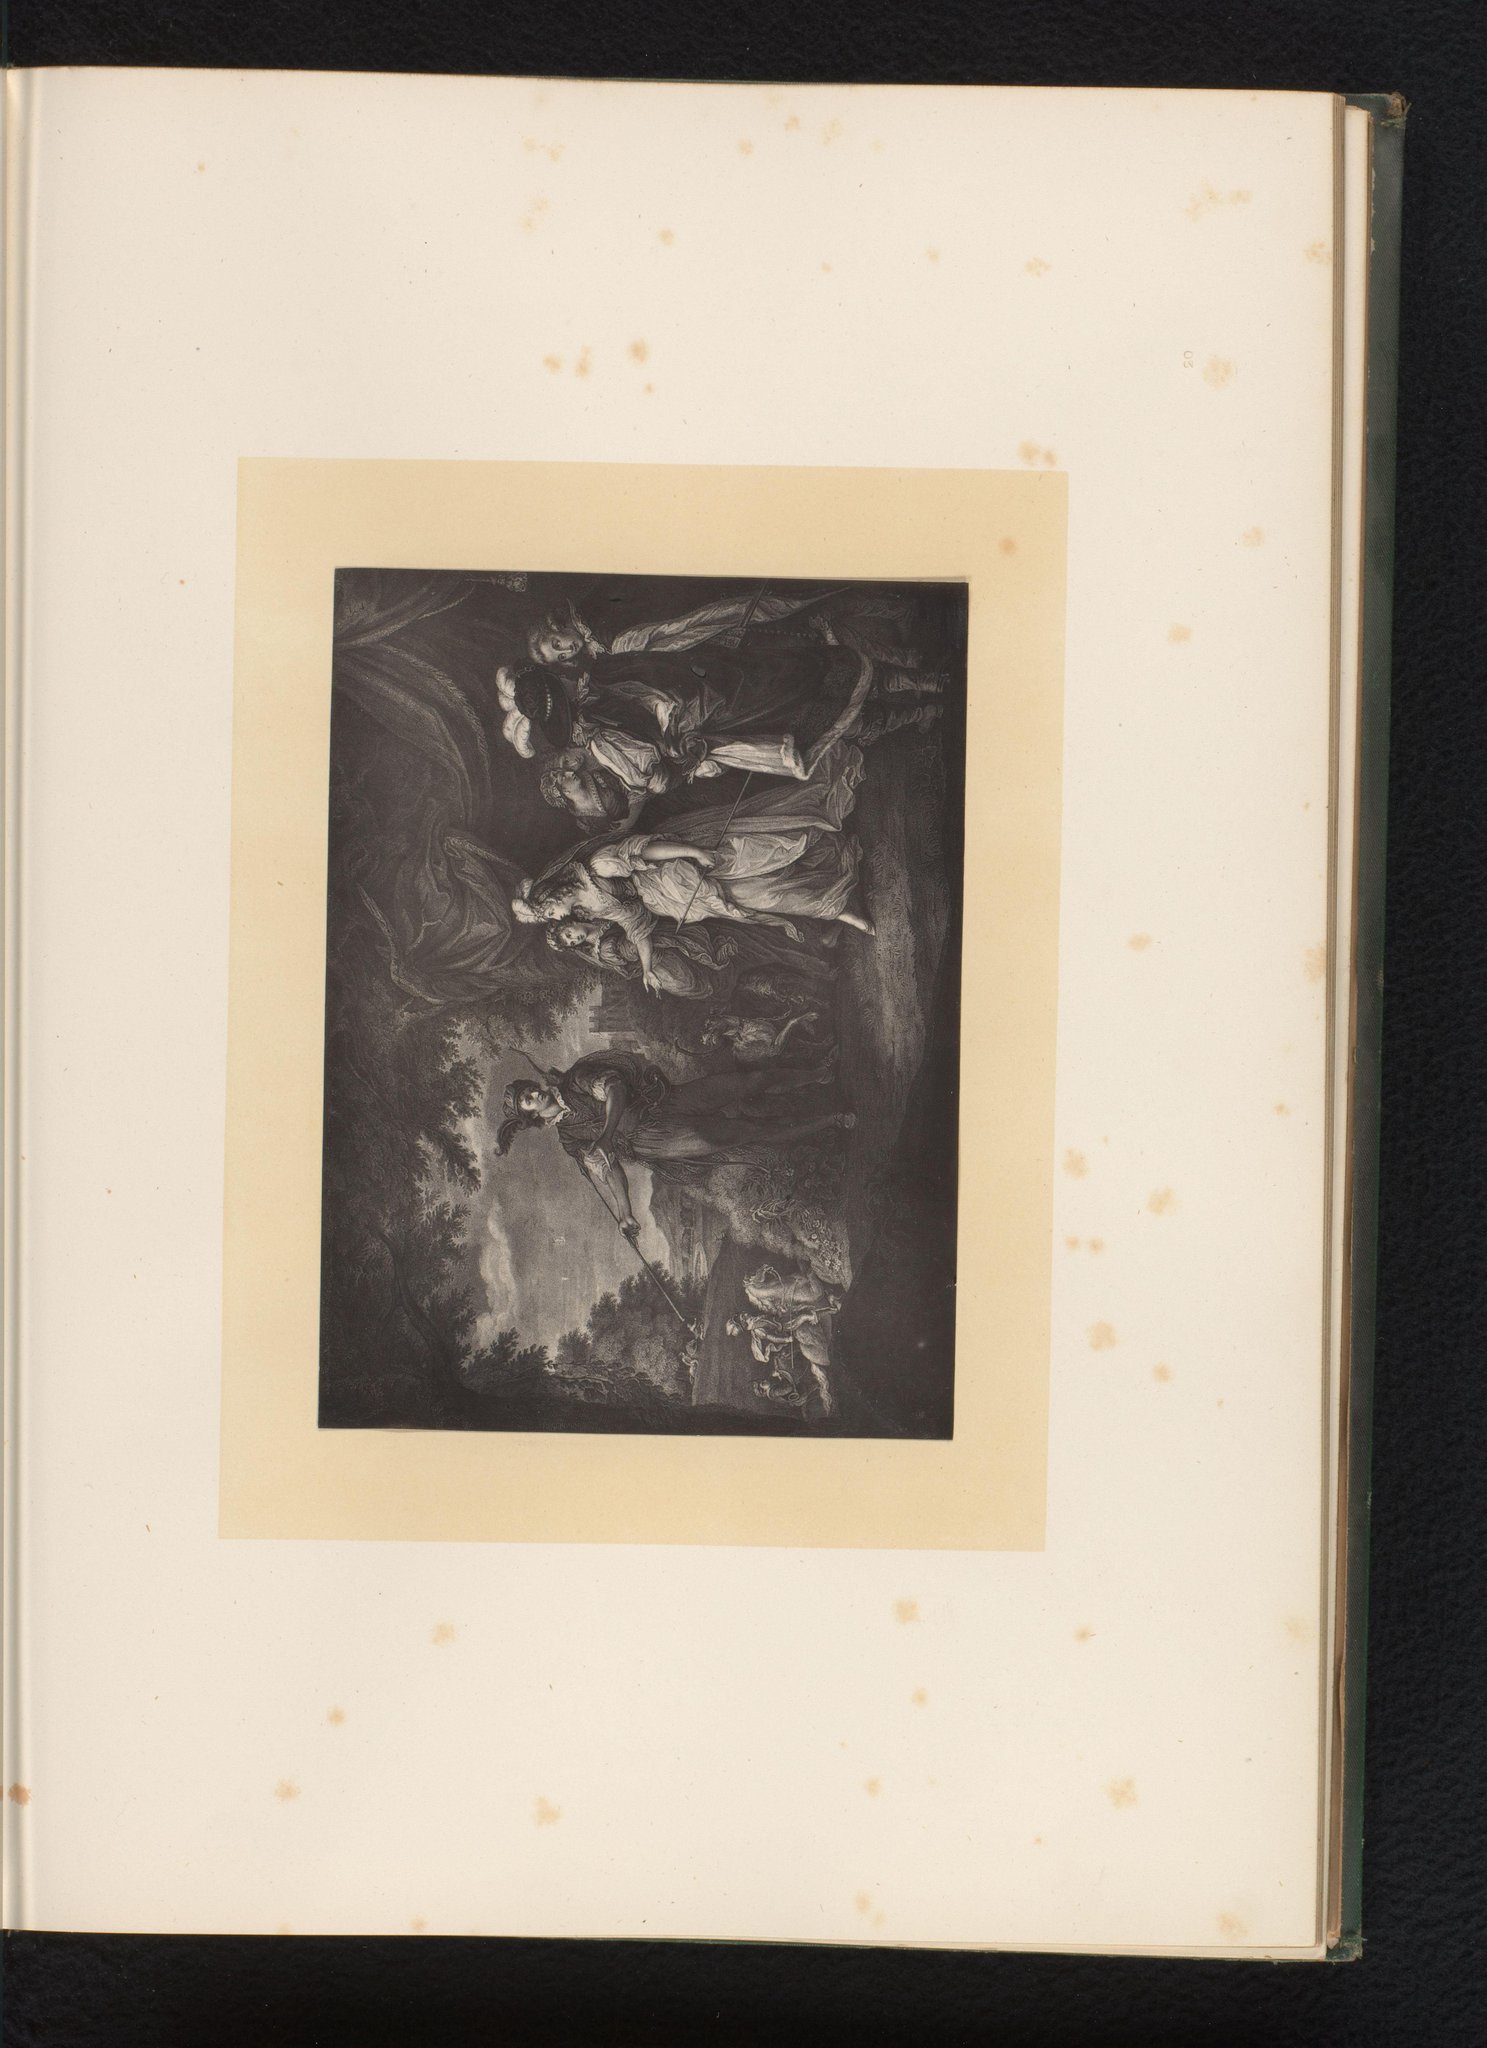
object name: reproduction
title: Love's Labour's Lost, Act IV, Scene 1: A Pavilion in the park, near the Palace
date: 1874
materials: paper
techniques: woodburytype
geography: london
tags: comedy